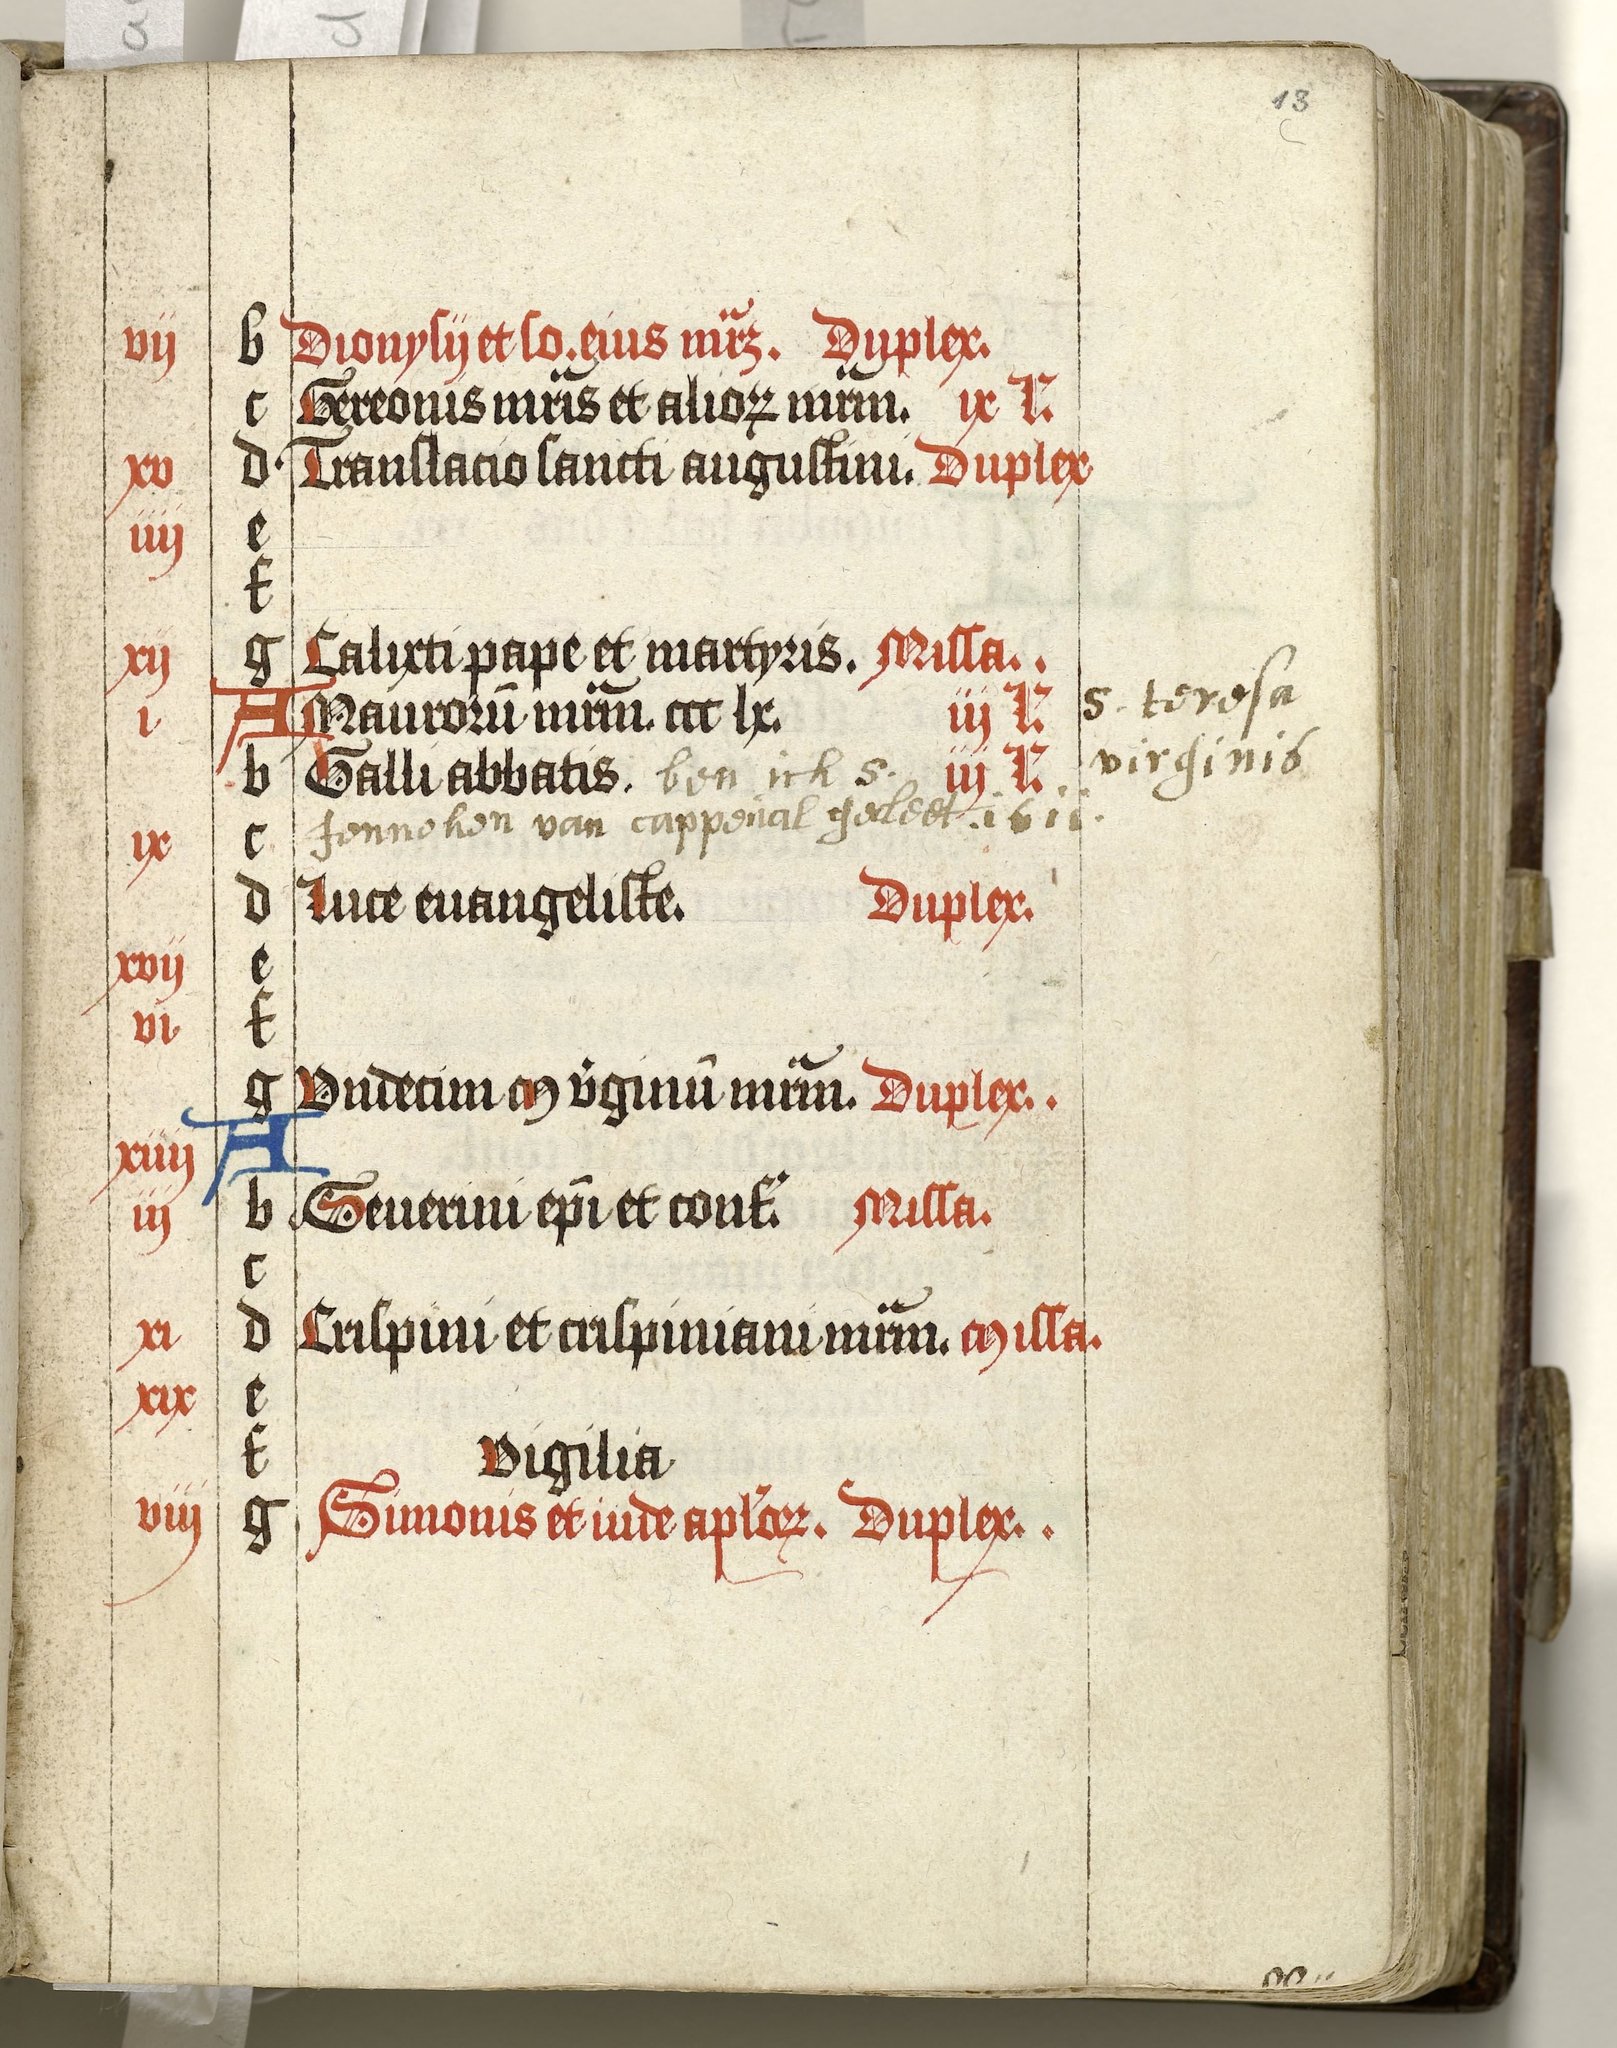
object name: book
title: Psalter en brevier (gedeeltes) in het Latijn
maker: Anonymous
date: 1500-1600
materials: paint, paper, parchment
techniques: pen in colors, brush in colors